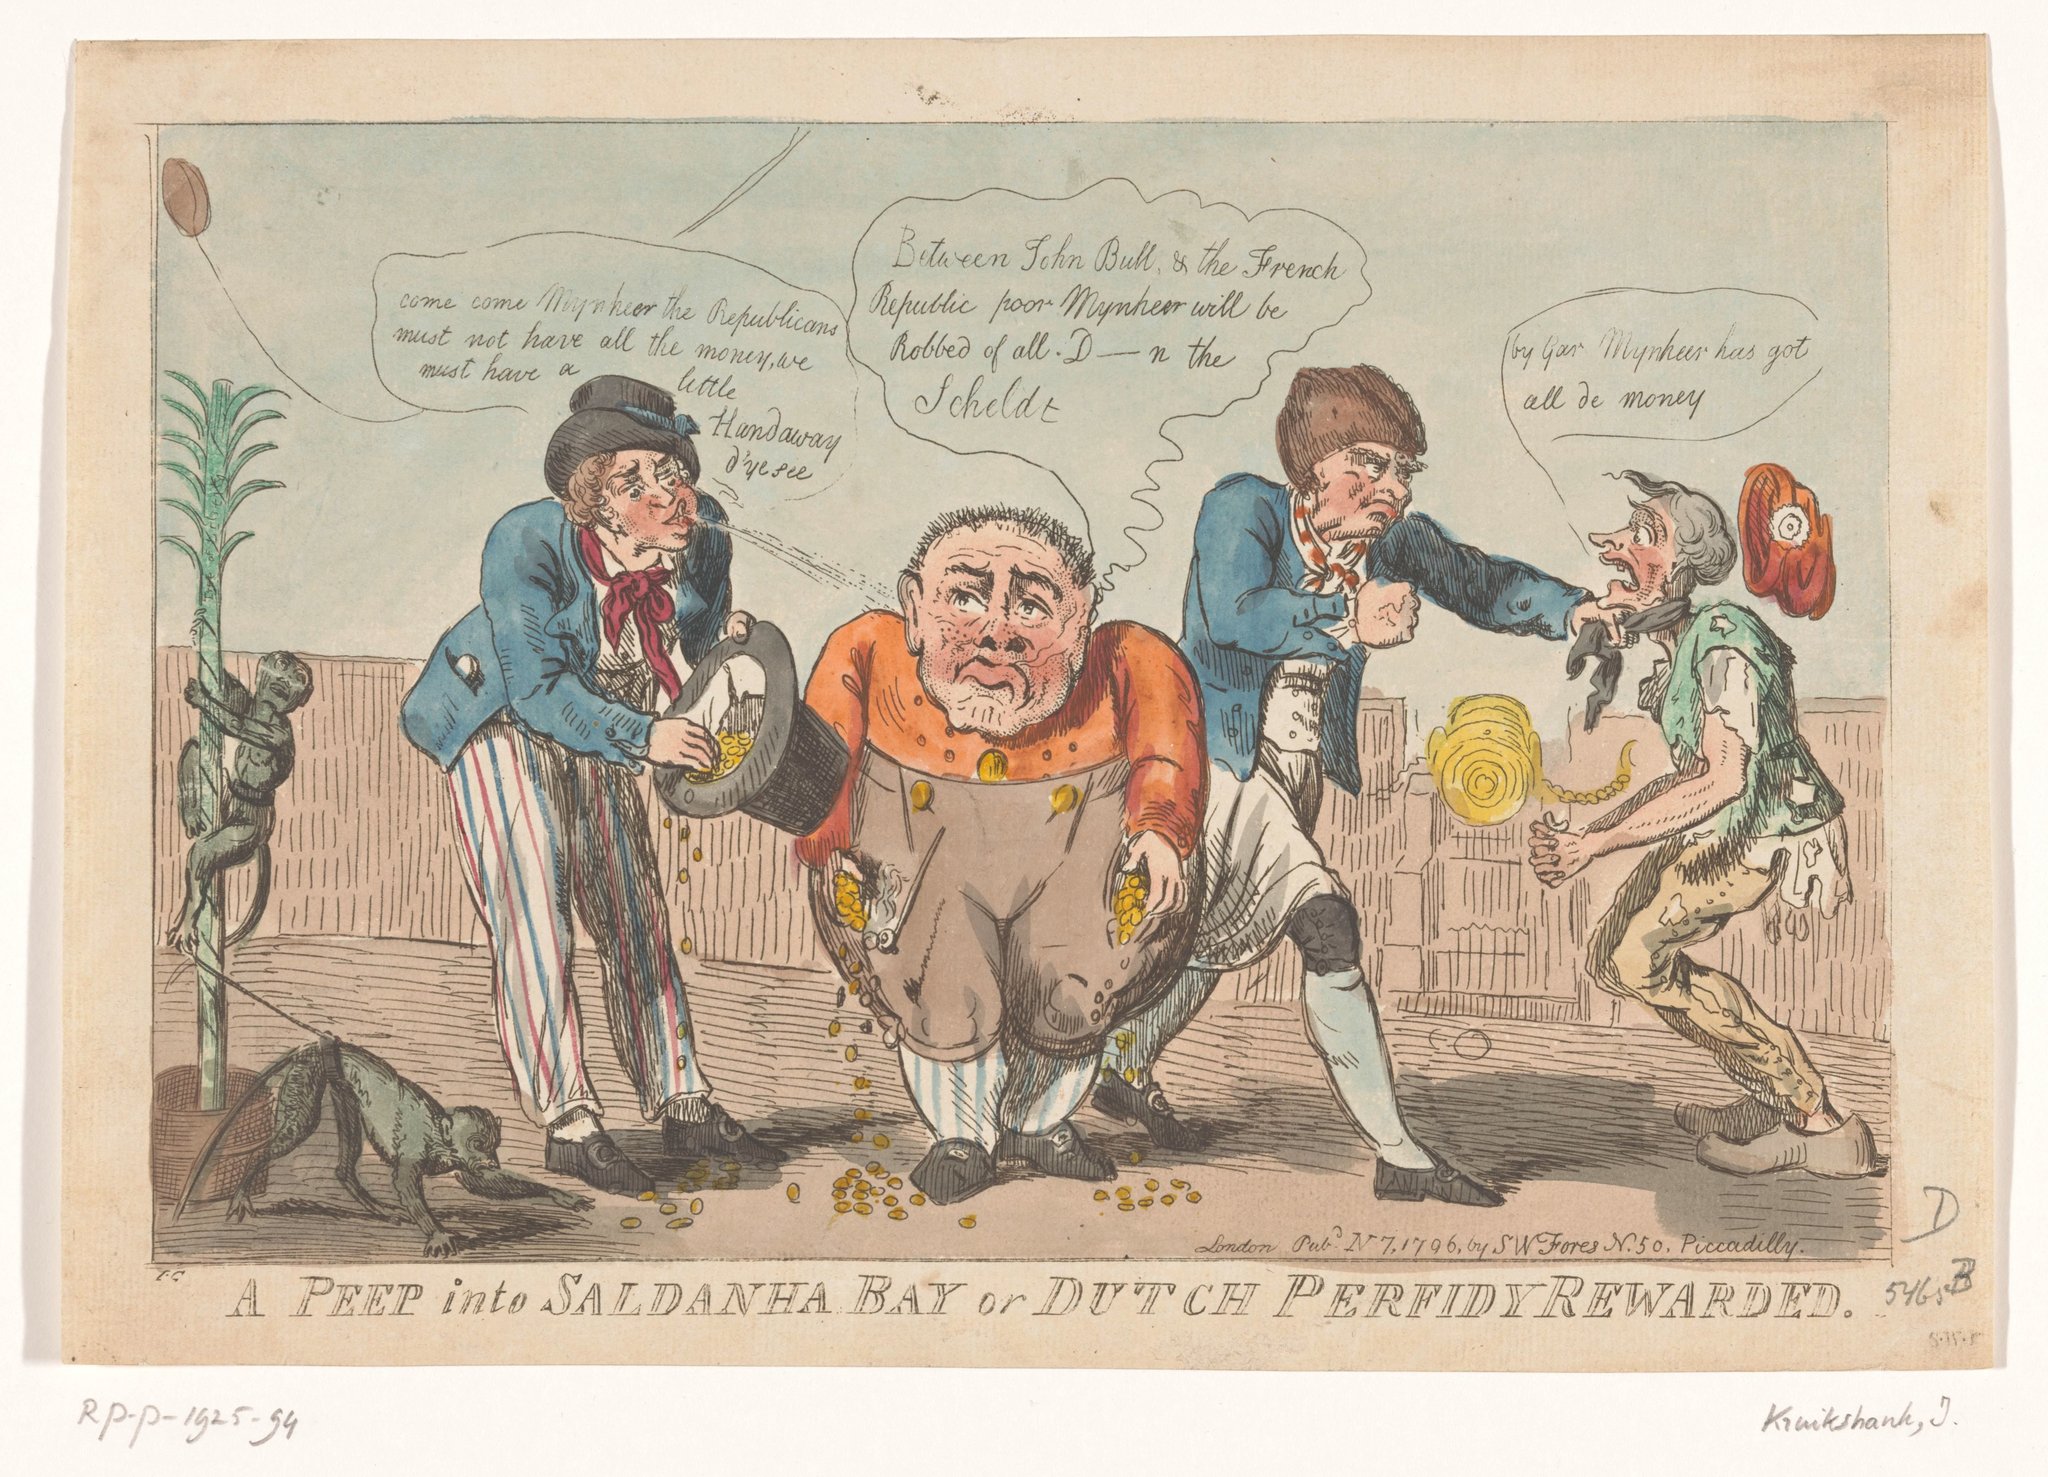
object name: cartoon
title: Spotprent op de capitulatie van de Bataafse vloot in de Saldanhabaai, 1796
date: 1796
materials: paper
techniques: etching, hand coloring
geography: london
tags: chewing-tobacco, spitting, robbery, political caricatures and satires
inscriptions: collector's mark: Lugt 2233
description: In een fort wordt een dikke Hollander met zakken gevuld met goudstukken door een Engelse matroos van zijn geld beroofd en in het gezicht gespuugd. Een andere Engelsman bedreigt een in lompen geklede Fransman. Links een vrijheidsboom met twee apen. Spotprent op de overgave van de Bataafse vloot van negen schepen aan de Engelsen in de Saldanhabaai aan de West-Kaap van Zuid-Afrika op 17 augustus 1796.